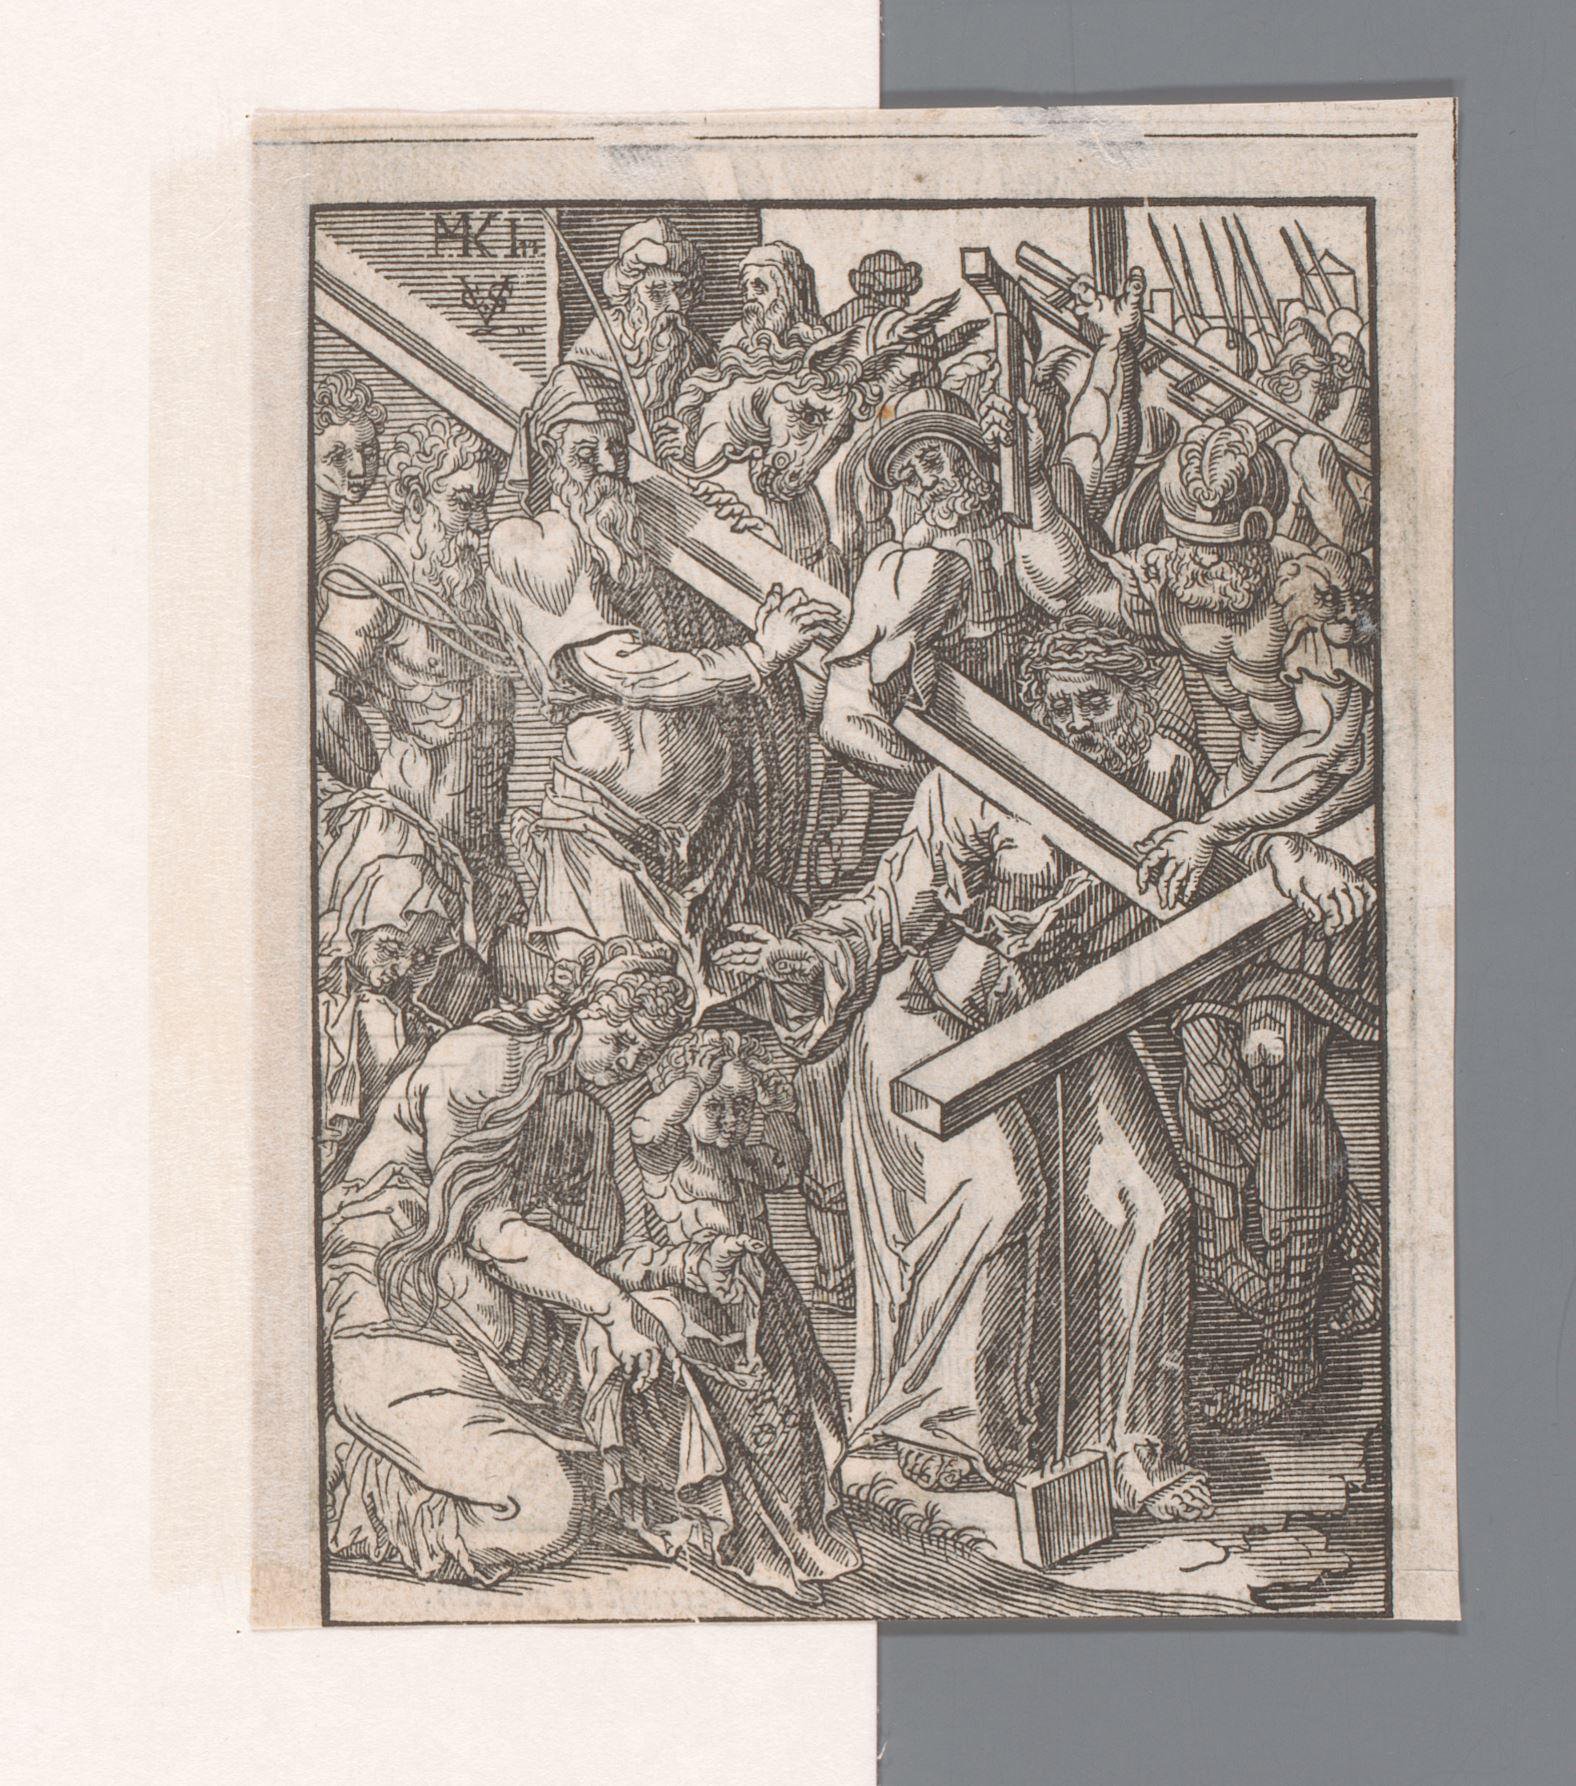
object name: book illustration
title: Kruisdraging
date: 1648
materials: paper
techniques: letterpress printing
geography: amsterdam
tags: christ meets veronica, who has a cloth to wipe christ's face, carrying of the cross: christ bearing the cross, alone or with the help of others (e.g. simon the cyrenian)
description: Prent uit: 't Schat der Zielen, dat is, het geheele leven ons Heeren Iesu Christi naer de vyer Evangelisten (...) in zeven stucken verdeelt. Amsterdam: Pieter Jacobsz. Paets, 1648. Deze prent komt uit het vijfde deel of hoofdstuk van 't Schat der zielen: Passie ons Heeren Iesu Christi, naer de beschrijvinghe van de vier evangelisten. Binnen het vijfde deel hoort deze prent bij de beschrijving van de passie door Lucas.